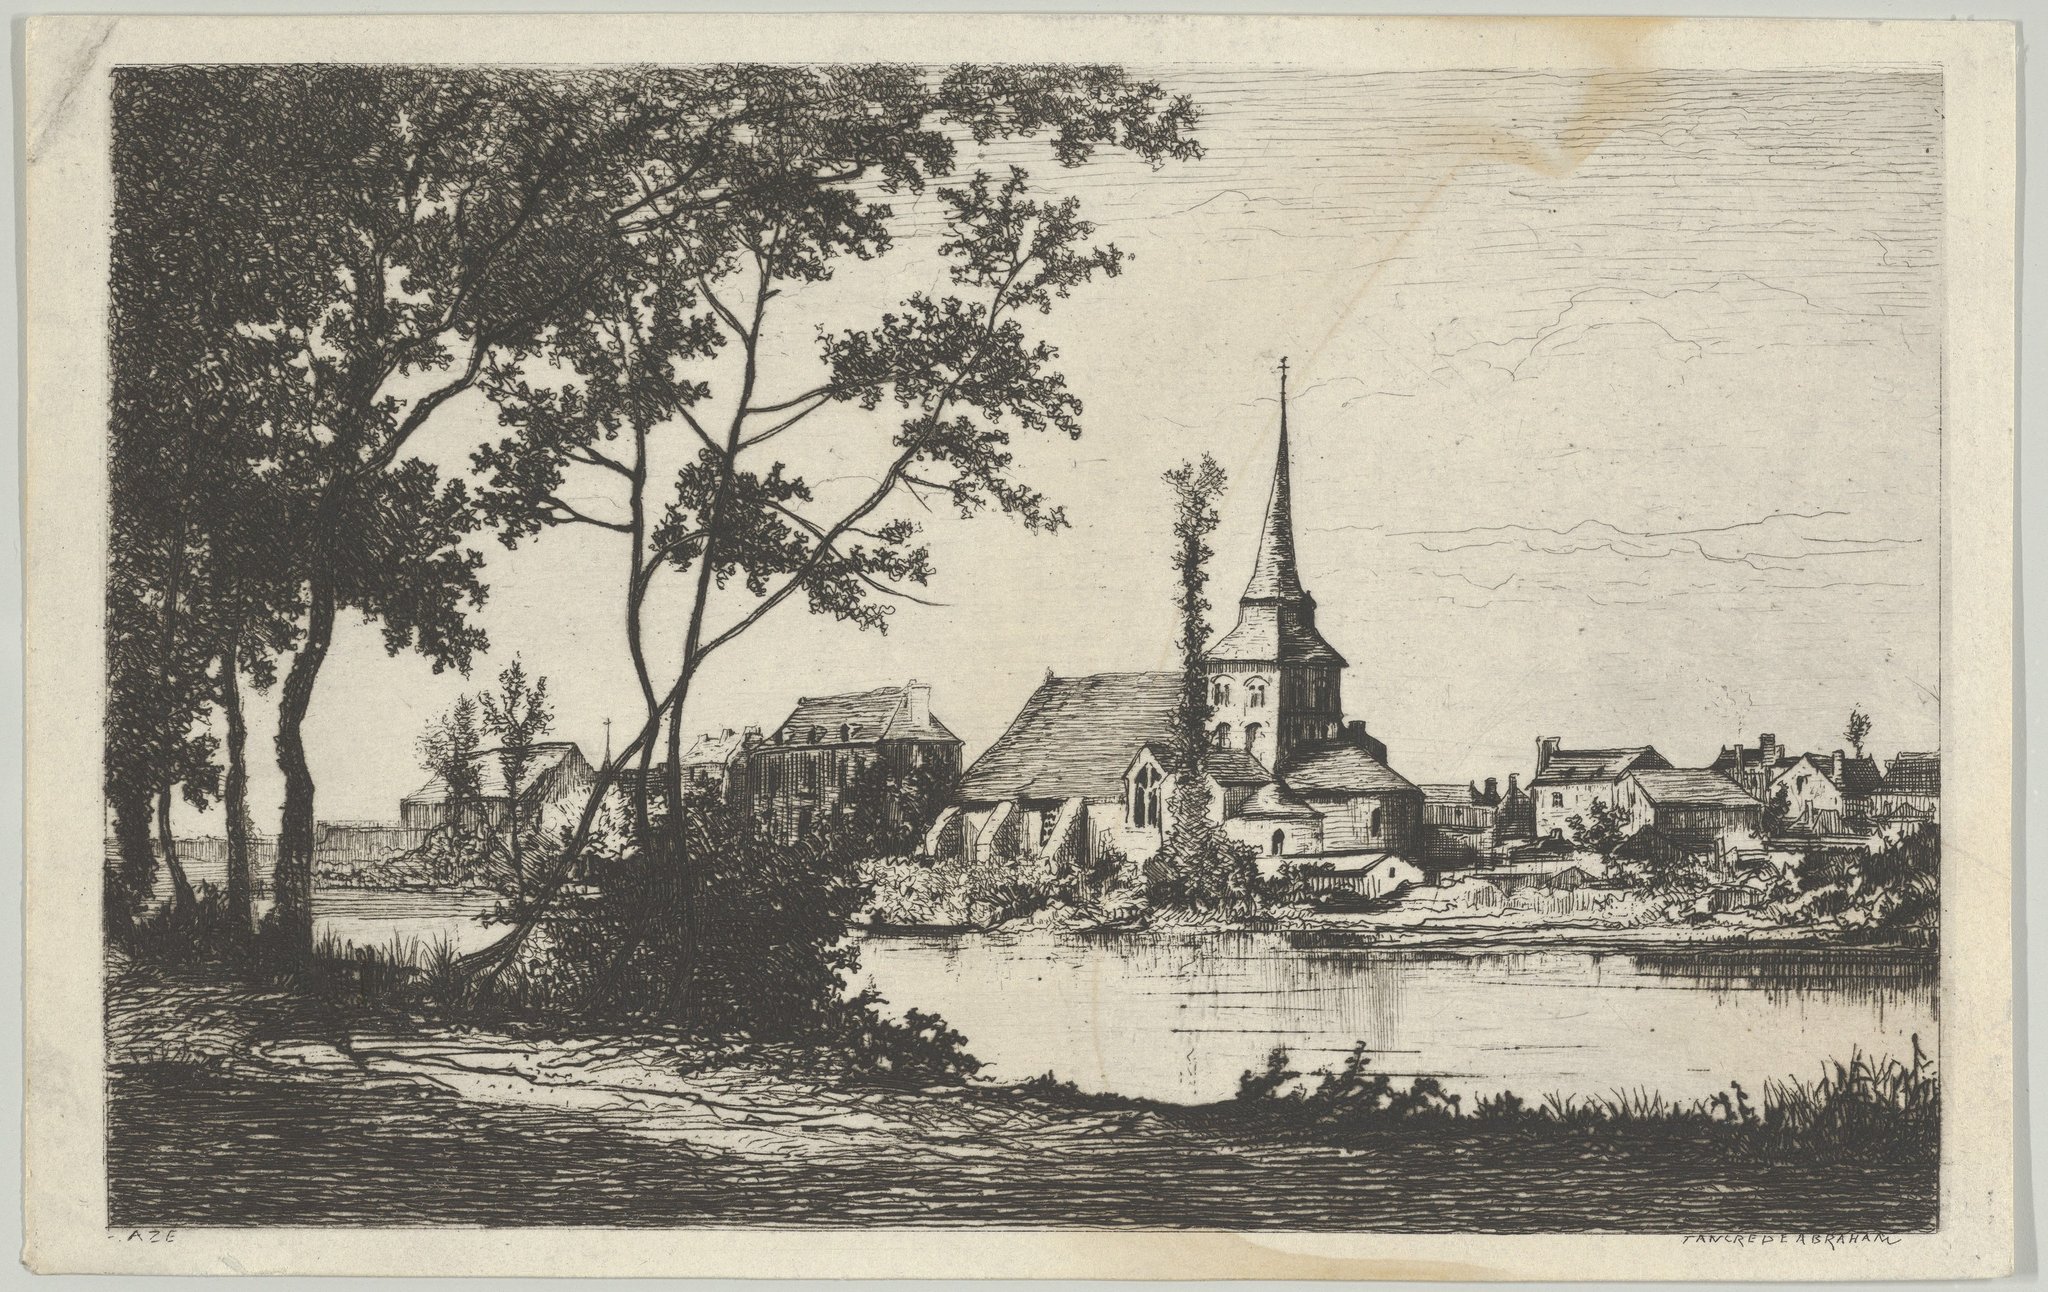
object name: print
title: Town with a church across a river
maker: tancrède abraham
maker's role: artist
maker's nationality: french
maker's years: 1836-1895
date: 1801-1900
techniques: drypoint, etching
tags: churches,towns,rivers,trees